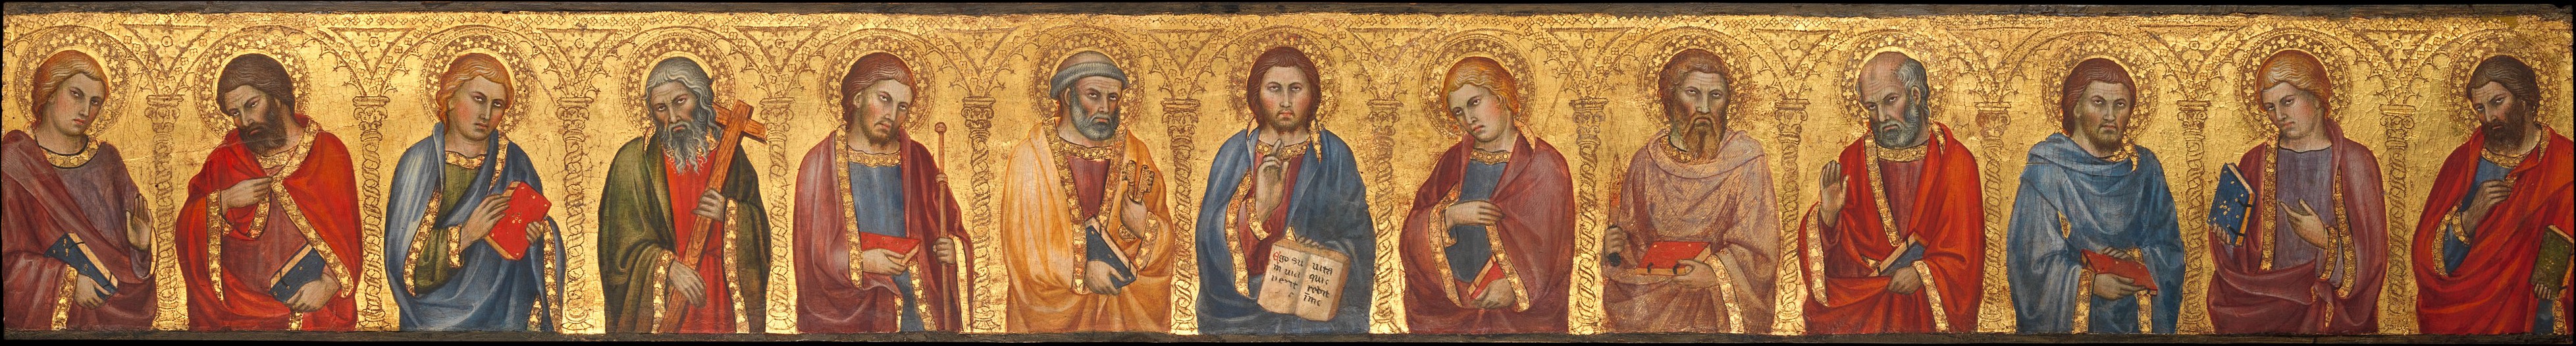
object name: painting, predella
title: Christ and the Twelve Apostles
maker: taddeo di bartolo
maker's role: artist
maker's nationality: italian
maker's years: 1362-1422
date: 1400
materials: gold leaf, paint, wood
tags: men,apostles,christ